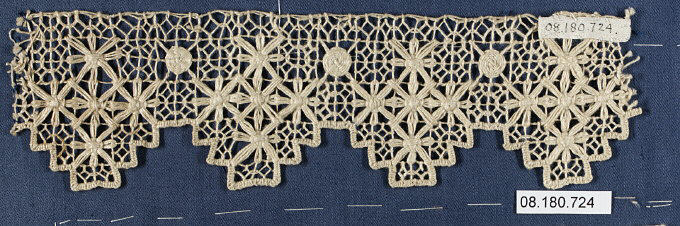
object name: fragment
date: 1801-1900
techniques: embroidery